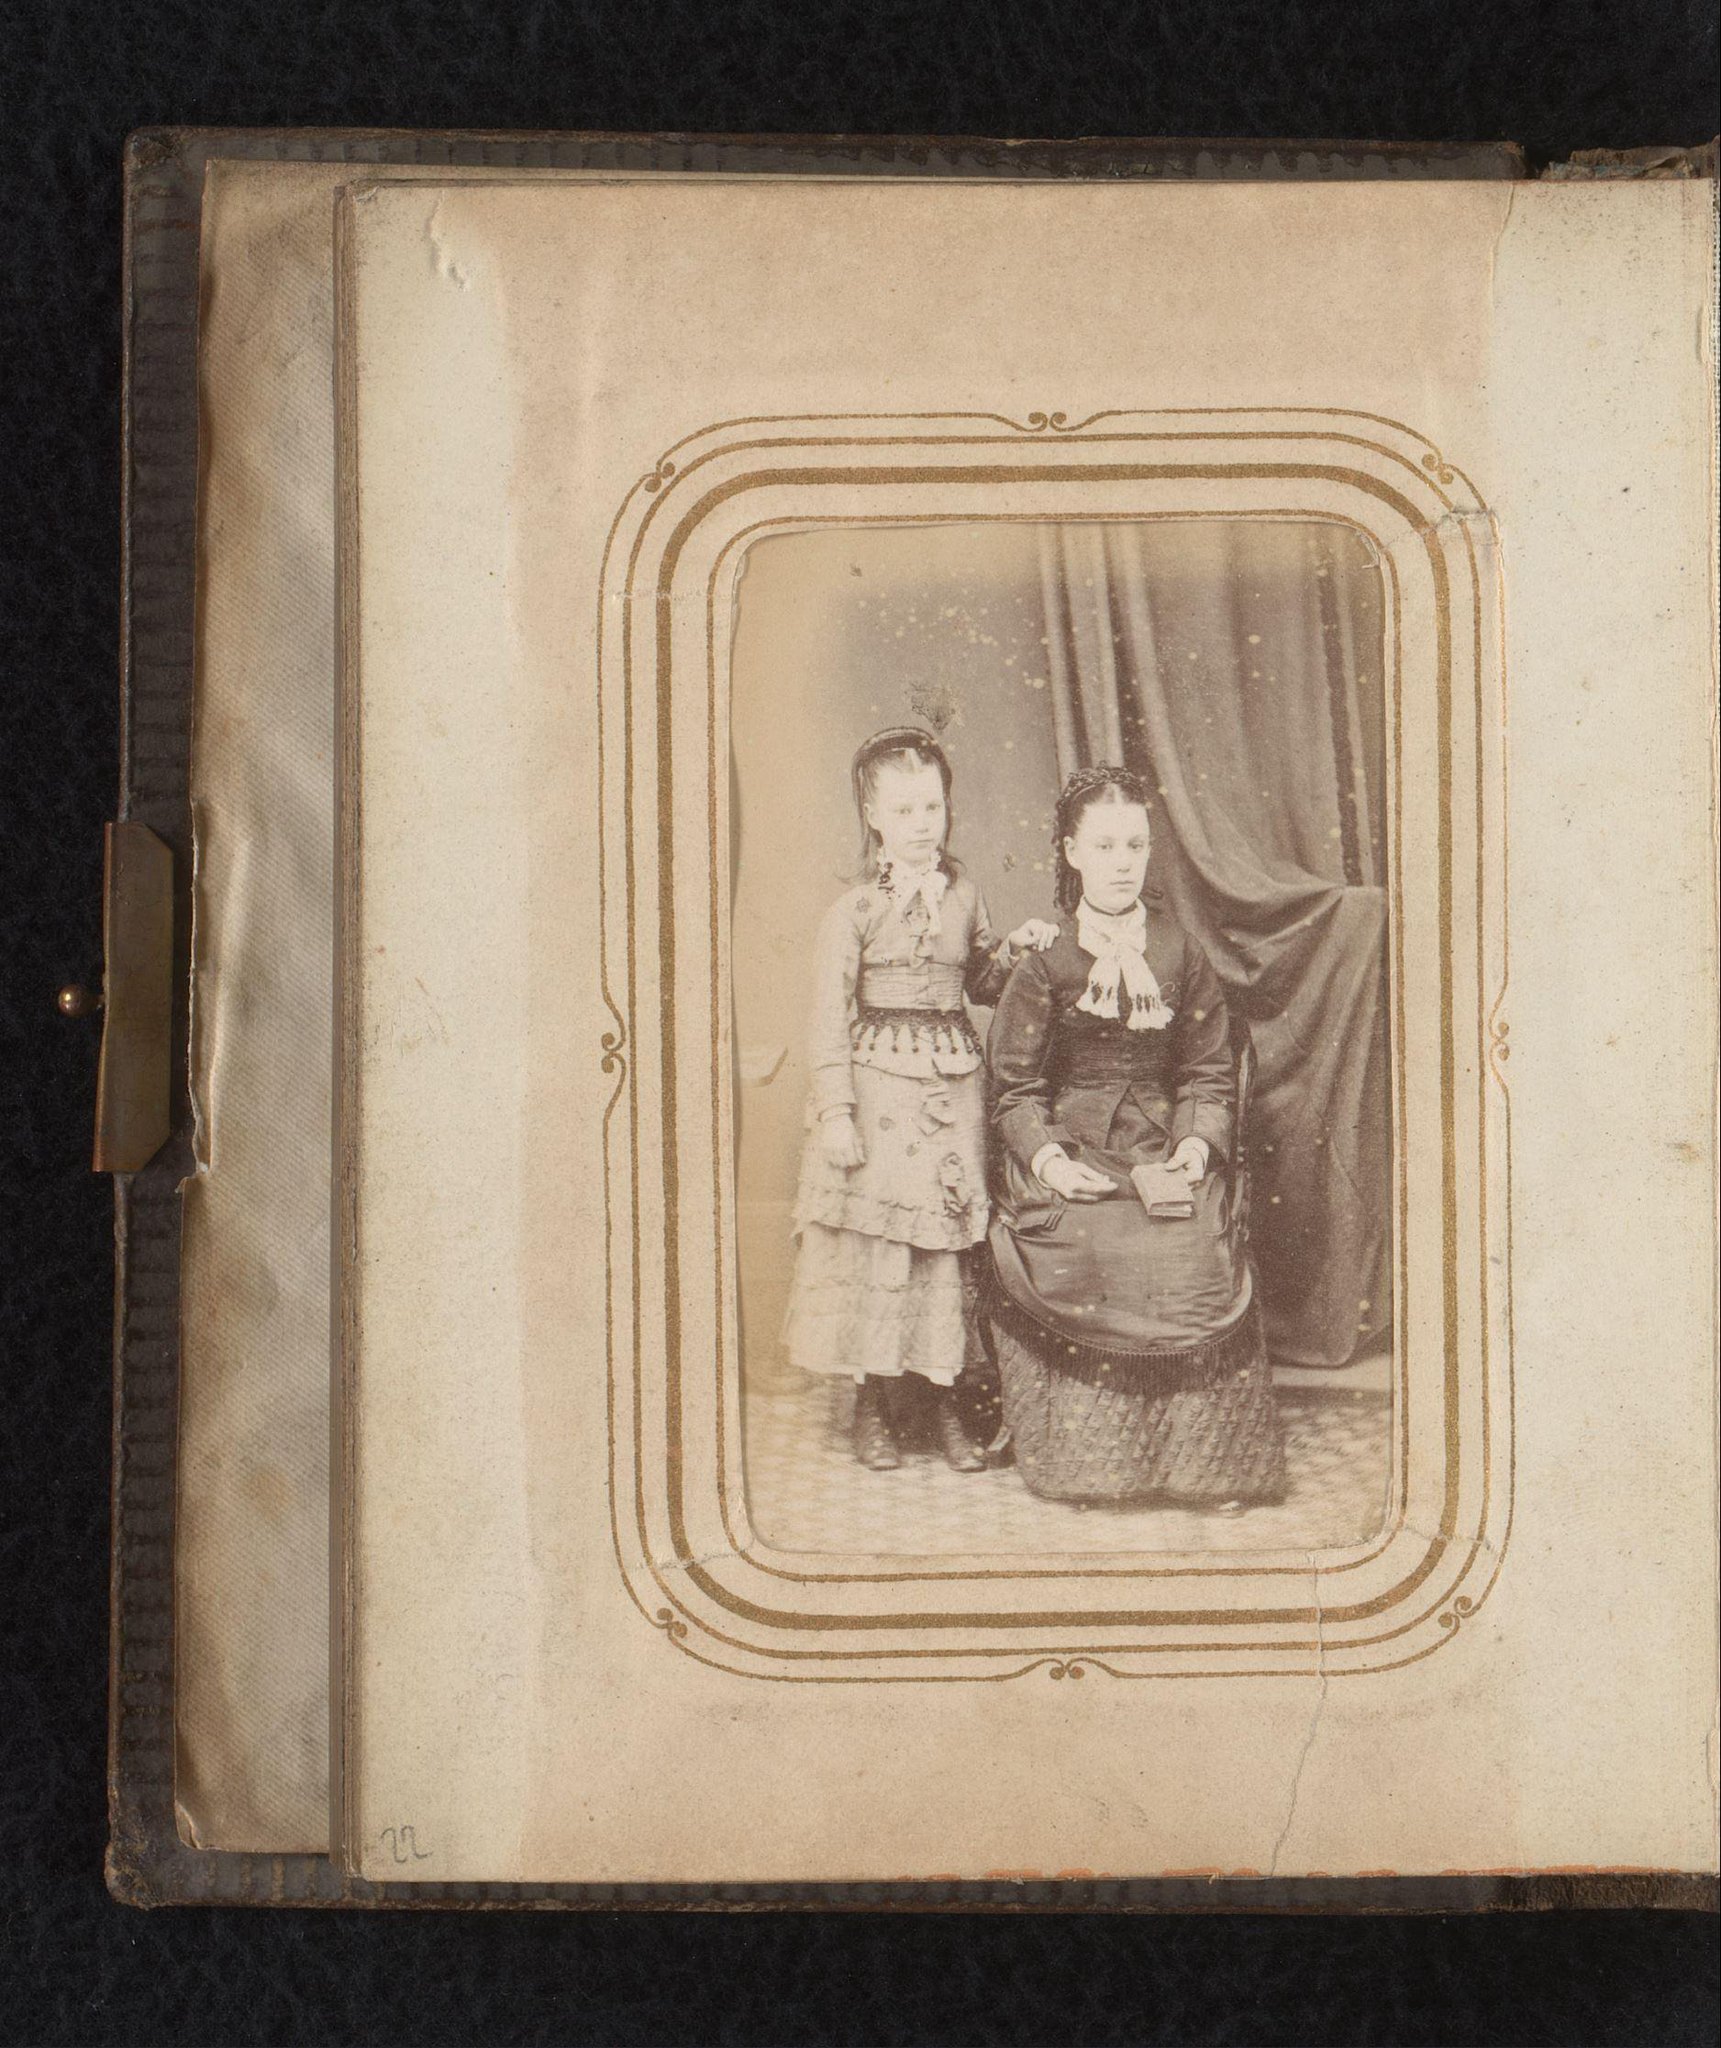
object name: album leaf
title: Portret van twee meisjes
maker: john bordley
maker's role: fotograaf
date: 1860-1900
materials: cardboard, photographic support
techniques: albumen print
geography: north yorkshire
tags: girl (child between toddler and youth)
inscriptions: inscription: ‘Jno Bordley/ Photographer/ Kirkgate, Settle’